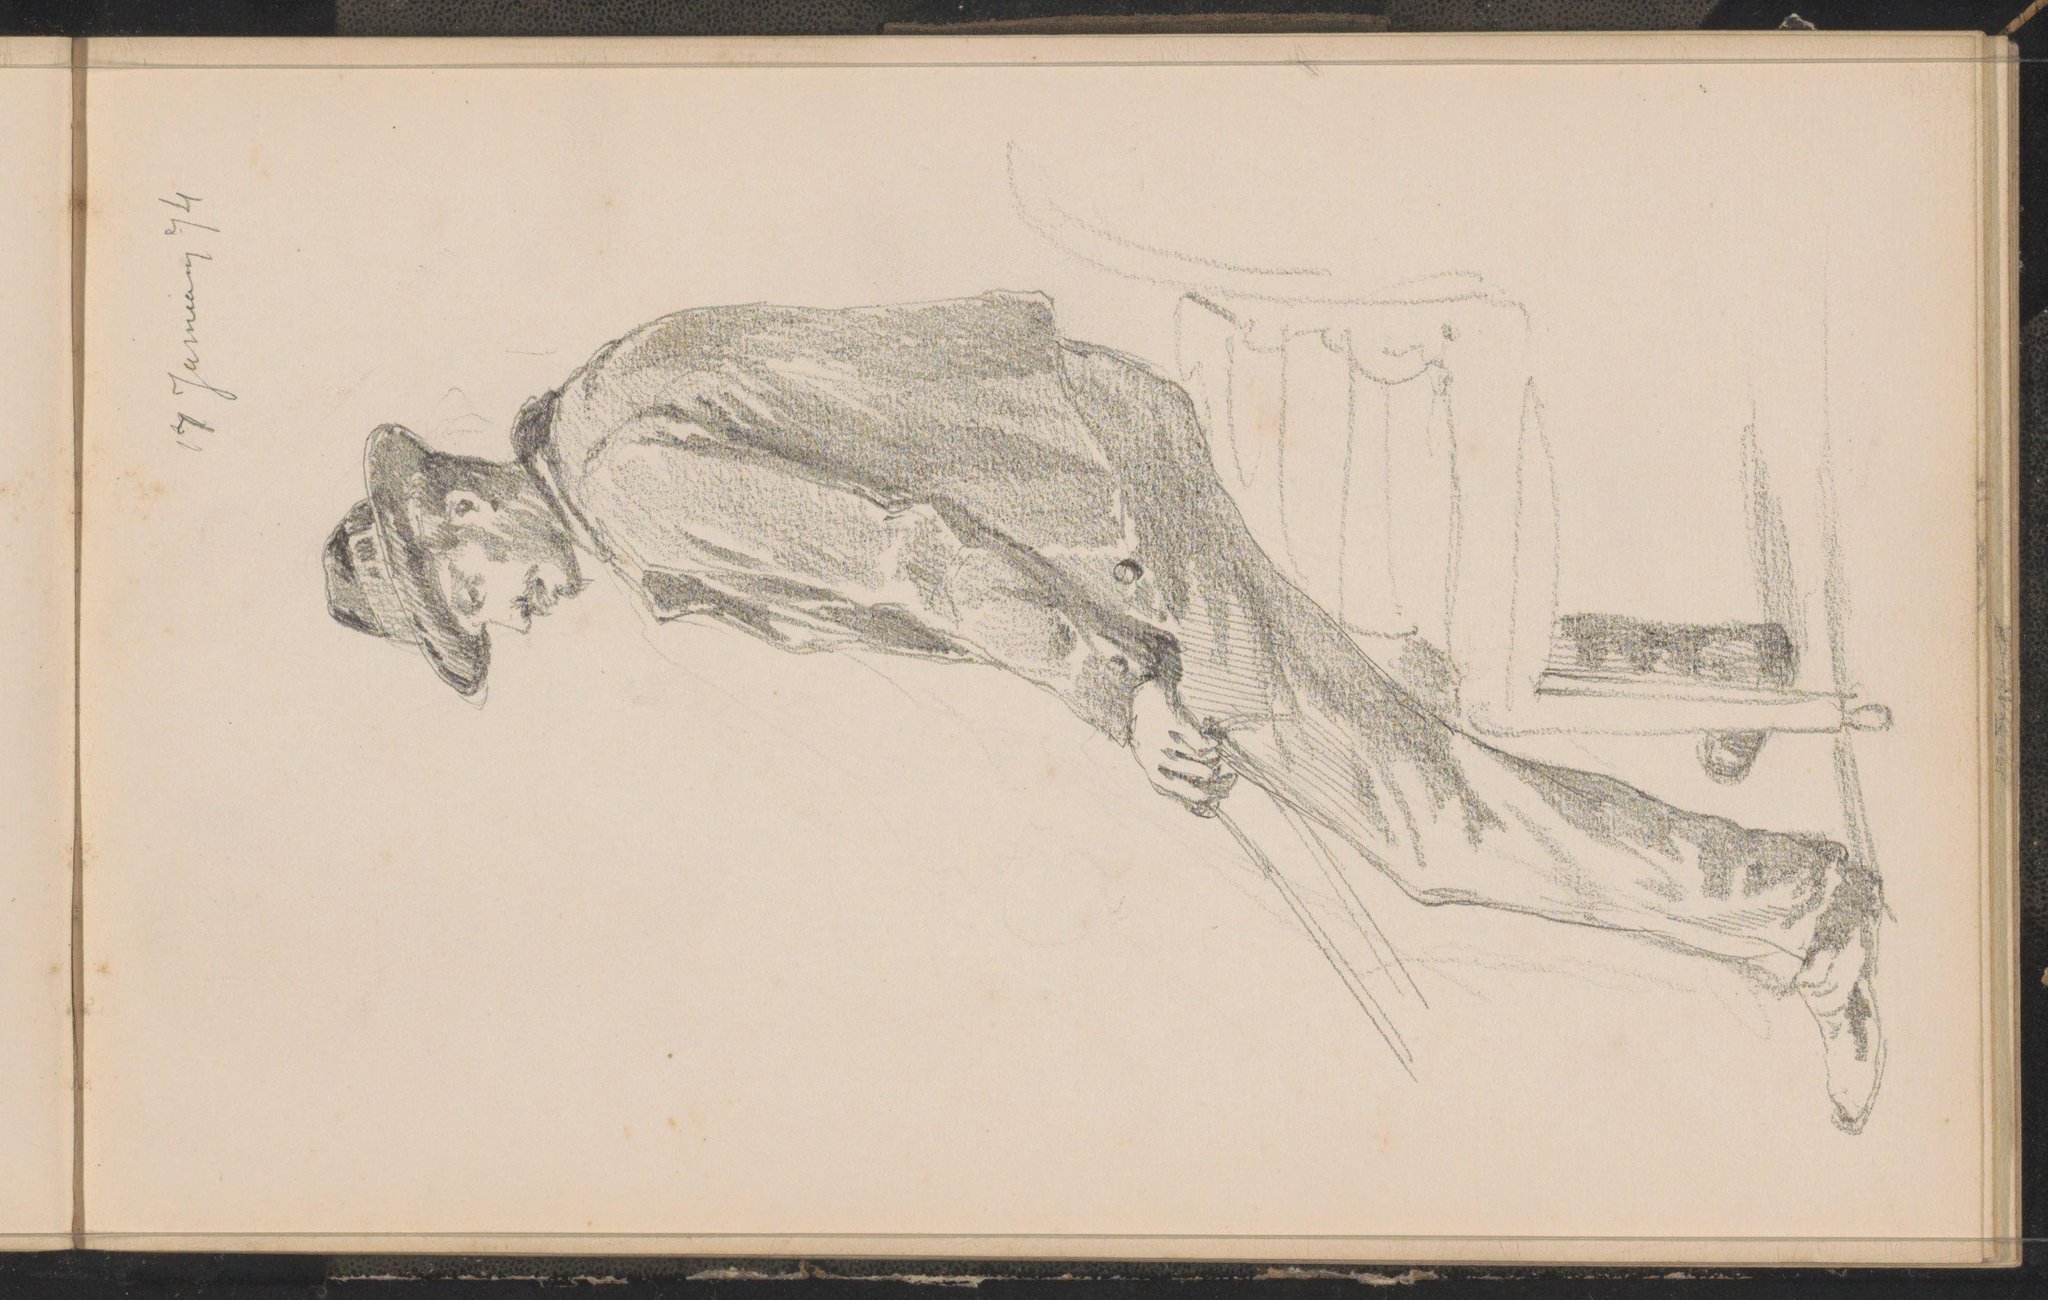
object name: sketchbook leaf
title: Man met hoed op een stoel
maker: cornelis springer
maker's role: draughtsman, painter, print maker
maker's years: 1817-1891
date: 1874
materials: paper, pencil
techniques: stumping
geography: netherlands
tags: sitting figure (+ sideview, profile), head-gear: hat (+ men's clothes), chair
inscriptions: date: ‘17 January 74’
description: Een man met een hoed zit op een stapel voorwerpen, die op een stoel ligt. In zijn hand mogelijk een leidsel. Blad 32 uit een schetsboek met 46 bladen.